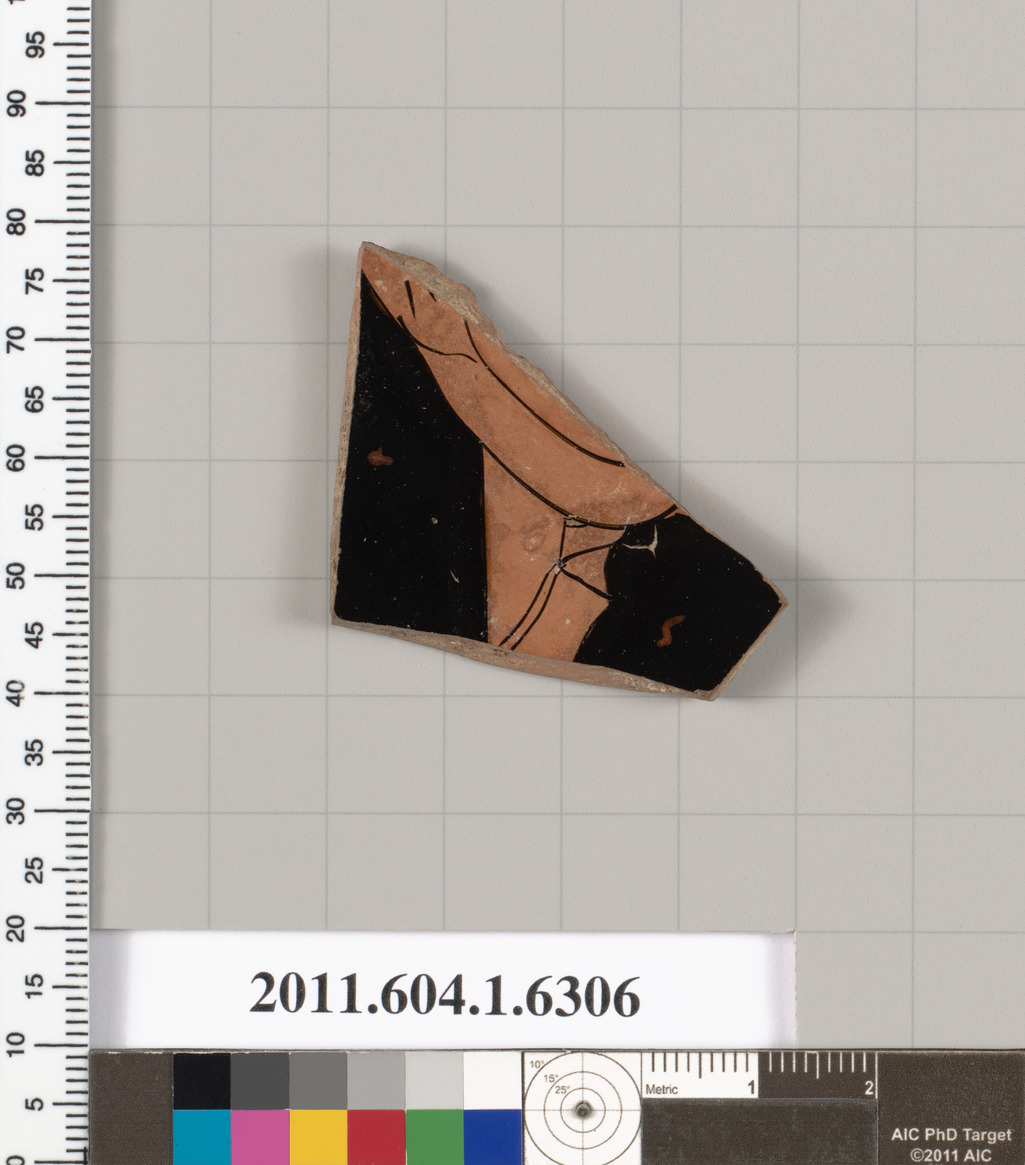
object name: kylix fragment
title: Terracotta fragment of a kylix (drinking cup)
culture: greek, attic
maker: onesimos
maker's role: artist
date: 500-480 BCE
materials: terracotta